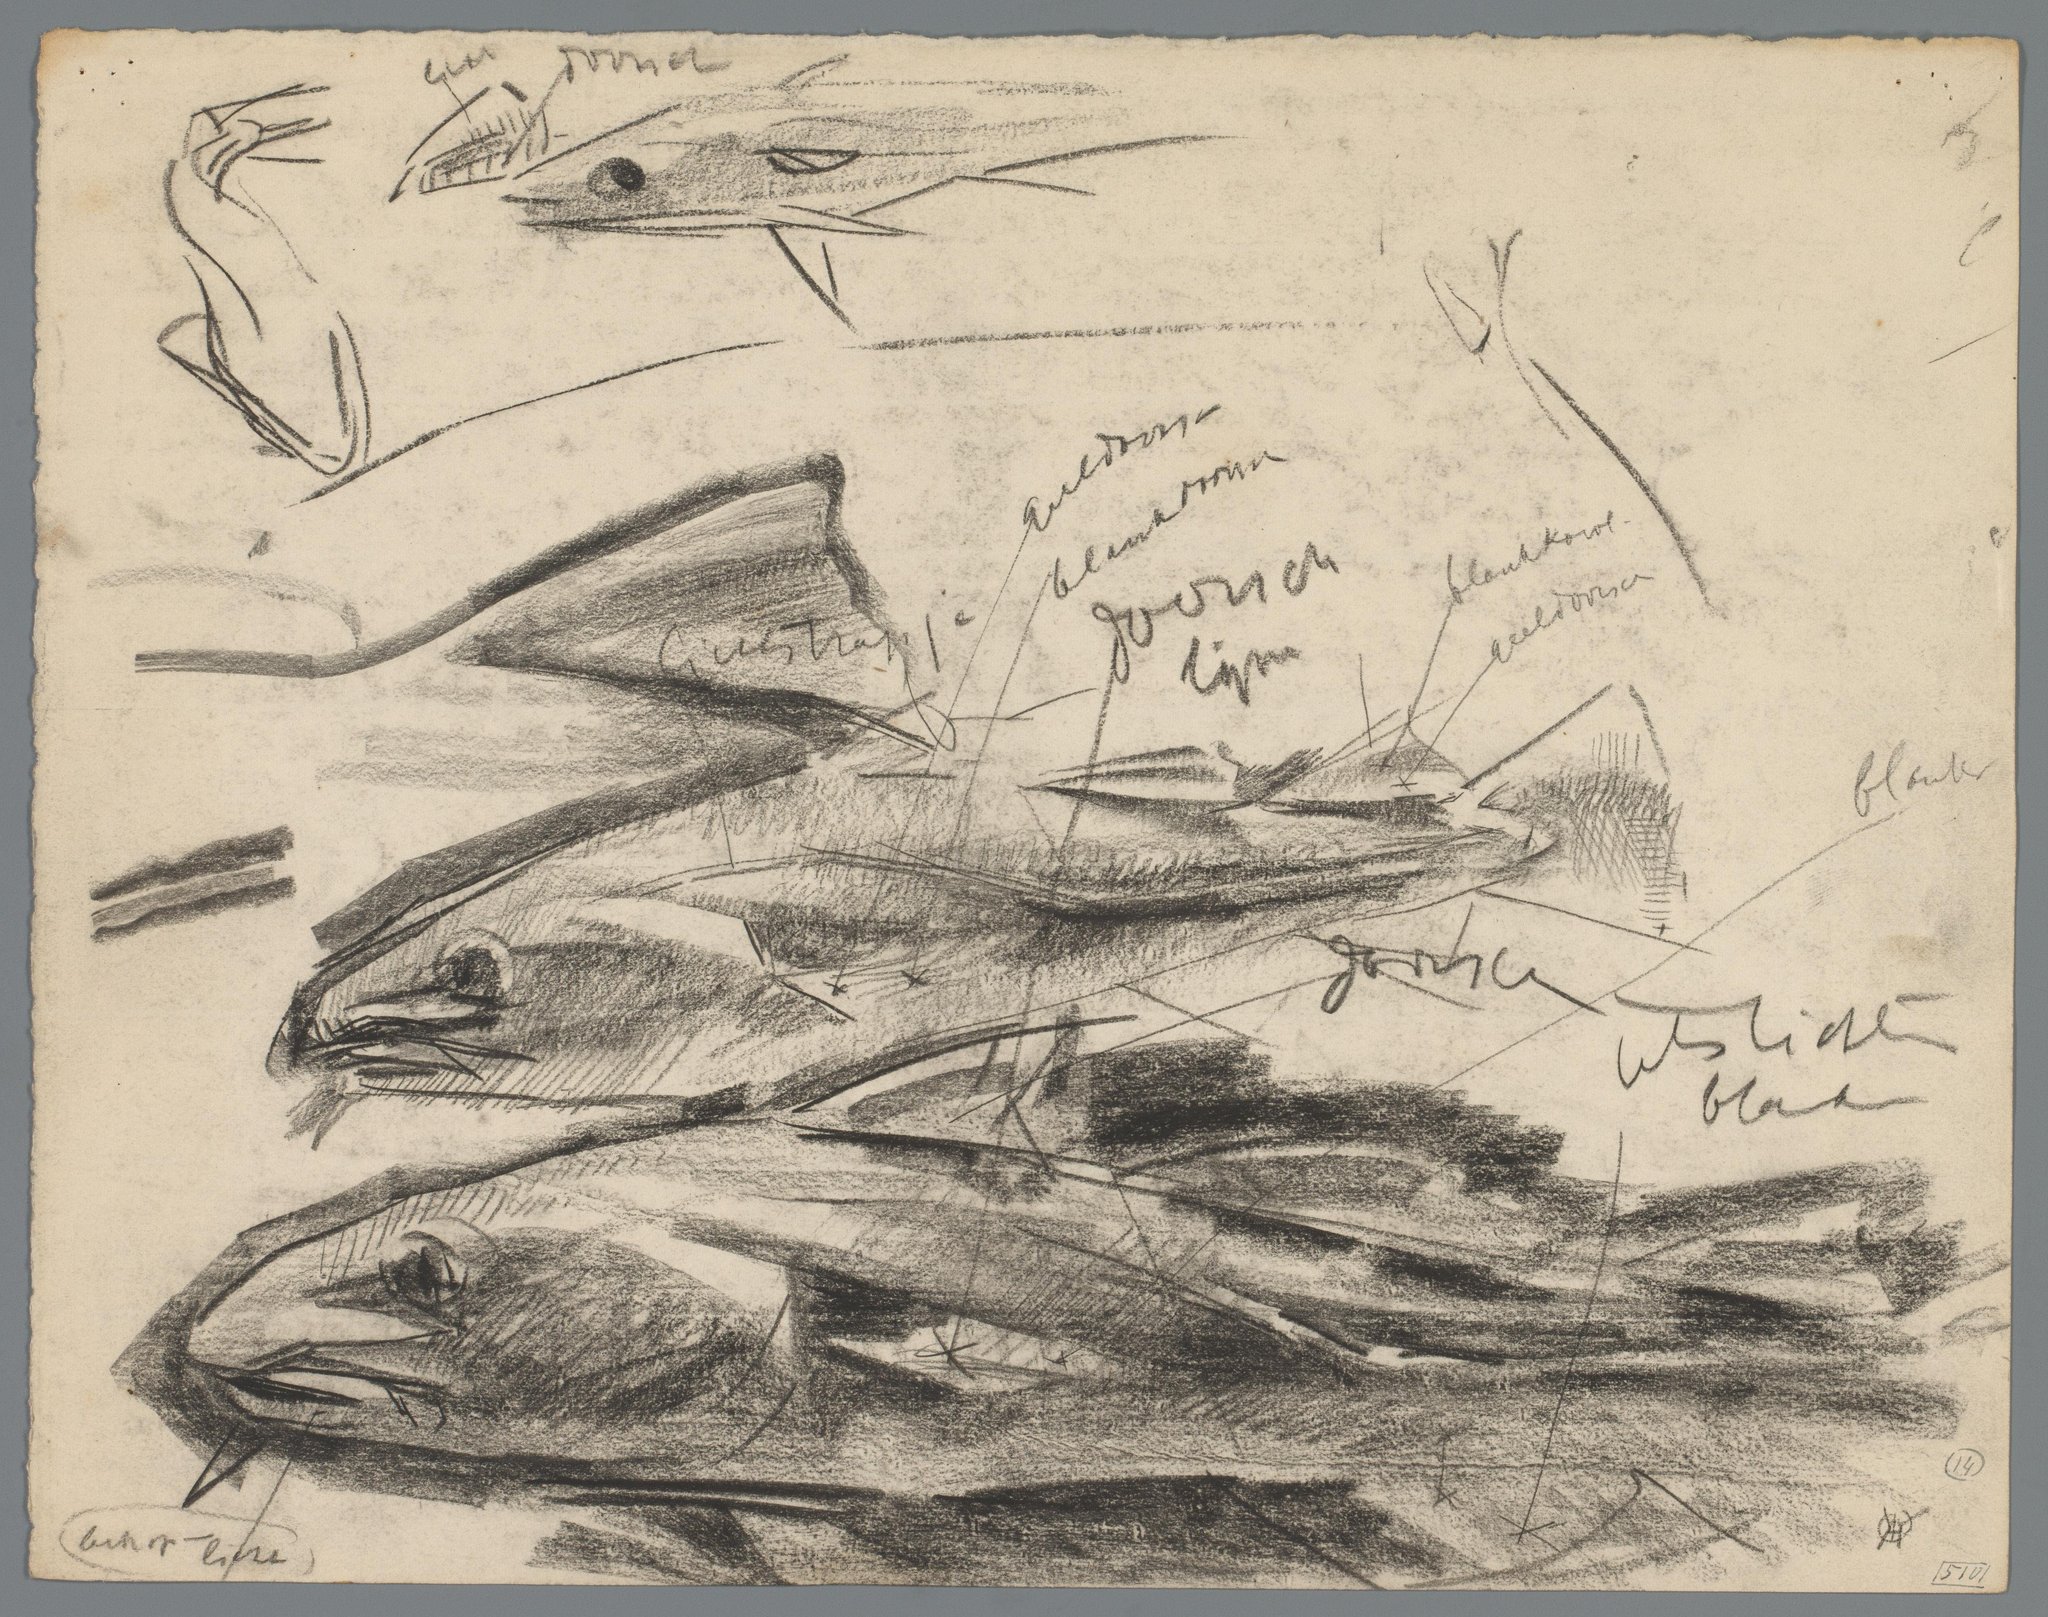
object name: drawing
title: Studies van kabeljauwen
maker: gerrit willem dijsselhof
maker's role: designer, draughtsman, print maker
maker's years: 1866-1924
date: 1876-1924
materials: chalk, paper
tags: fishes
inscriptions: number: ‘510’, number: ‘14’